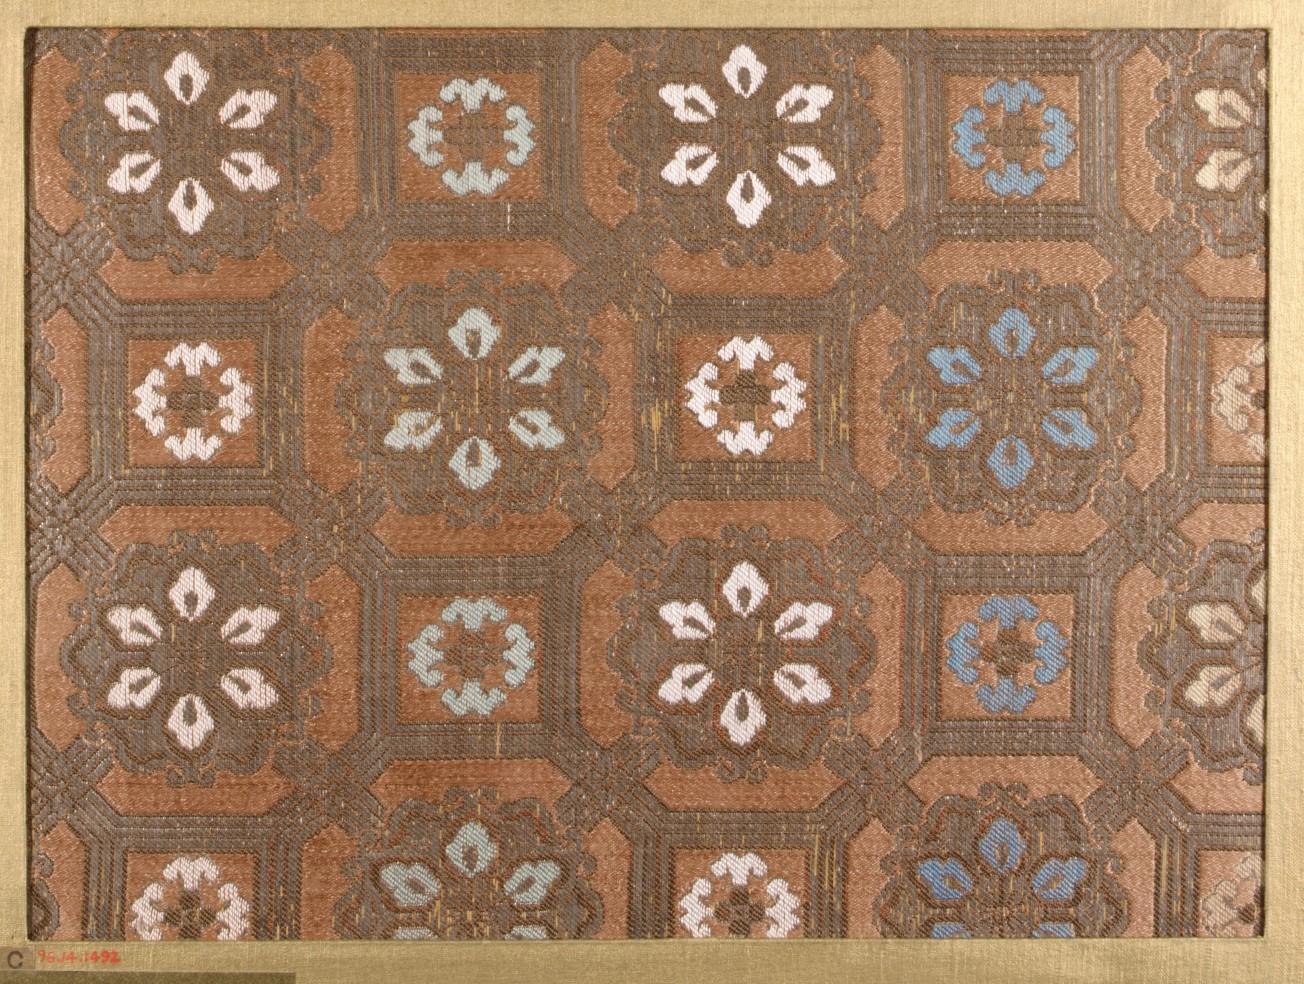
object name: piece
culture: japanese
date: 1701-1900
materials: silk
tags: flowers